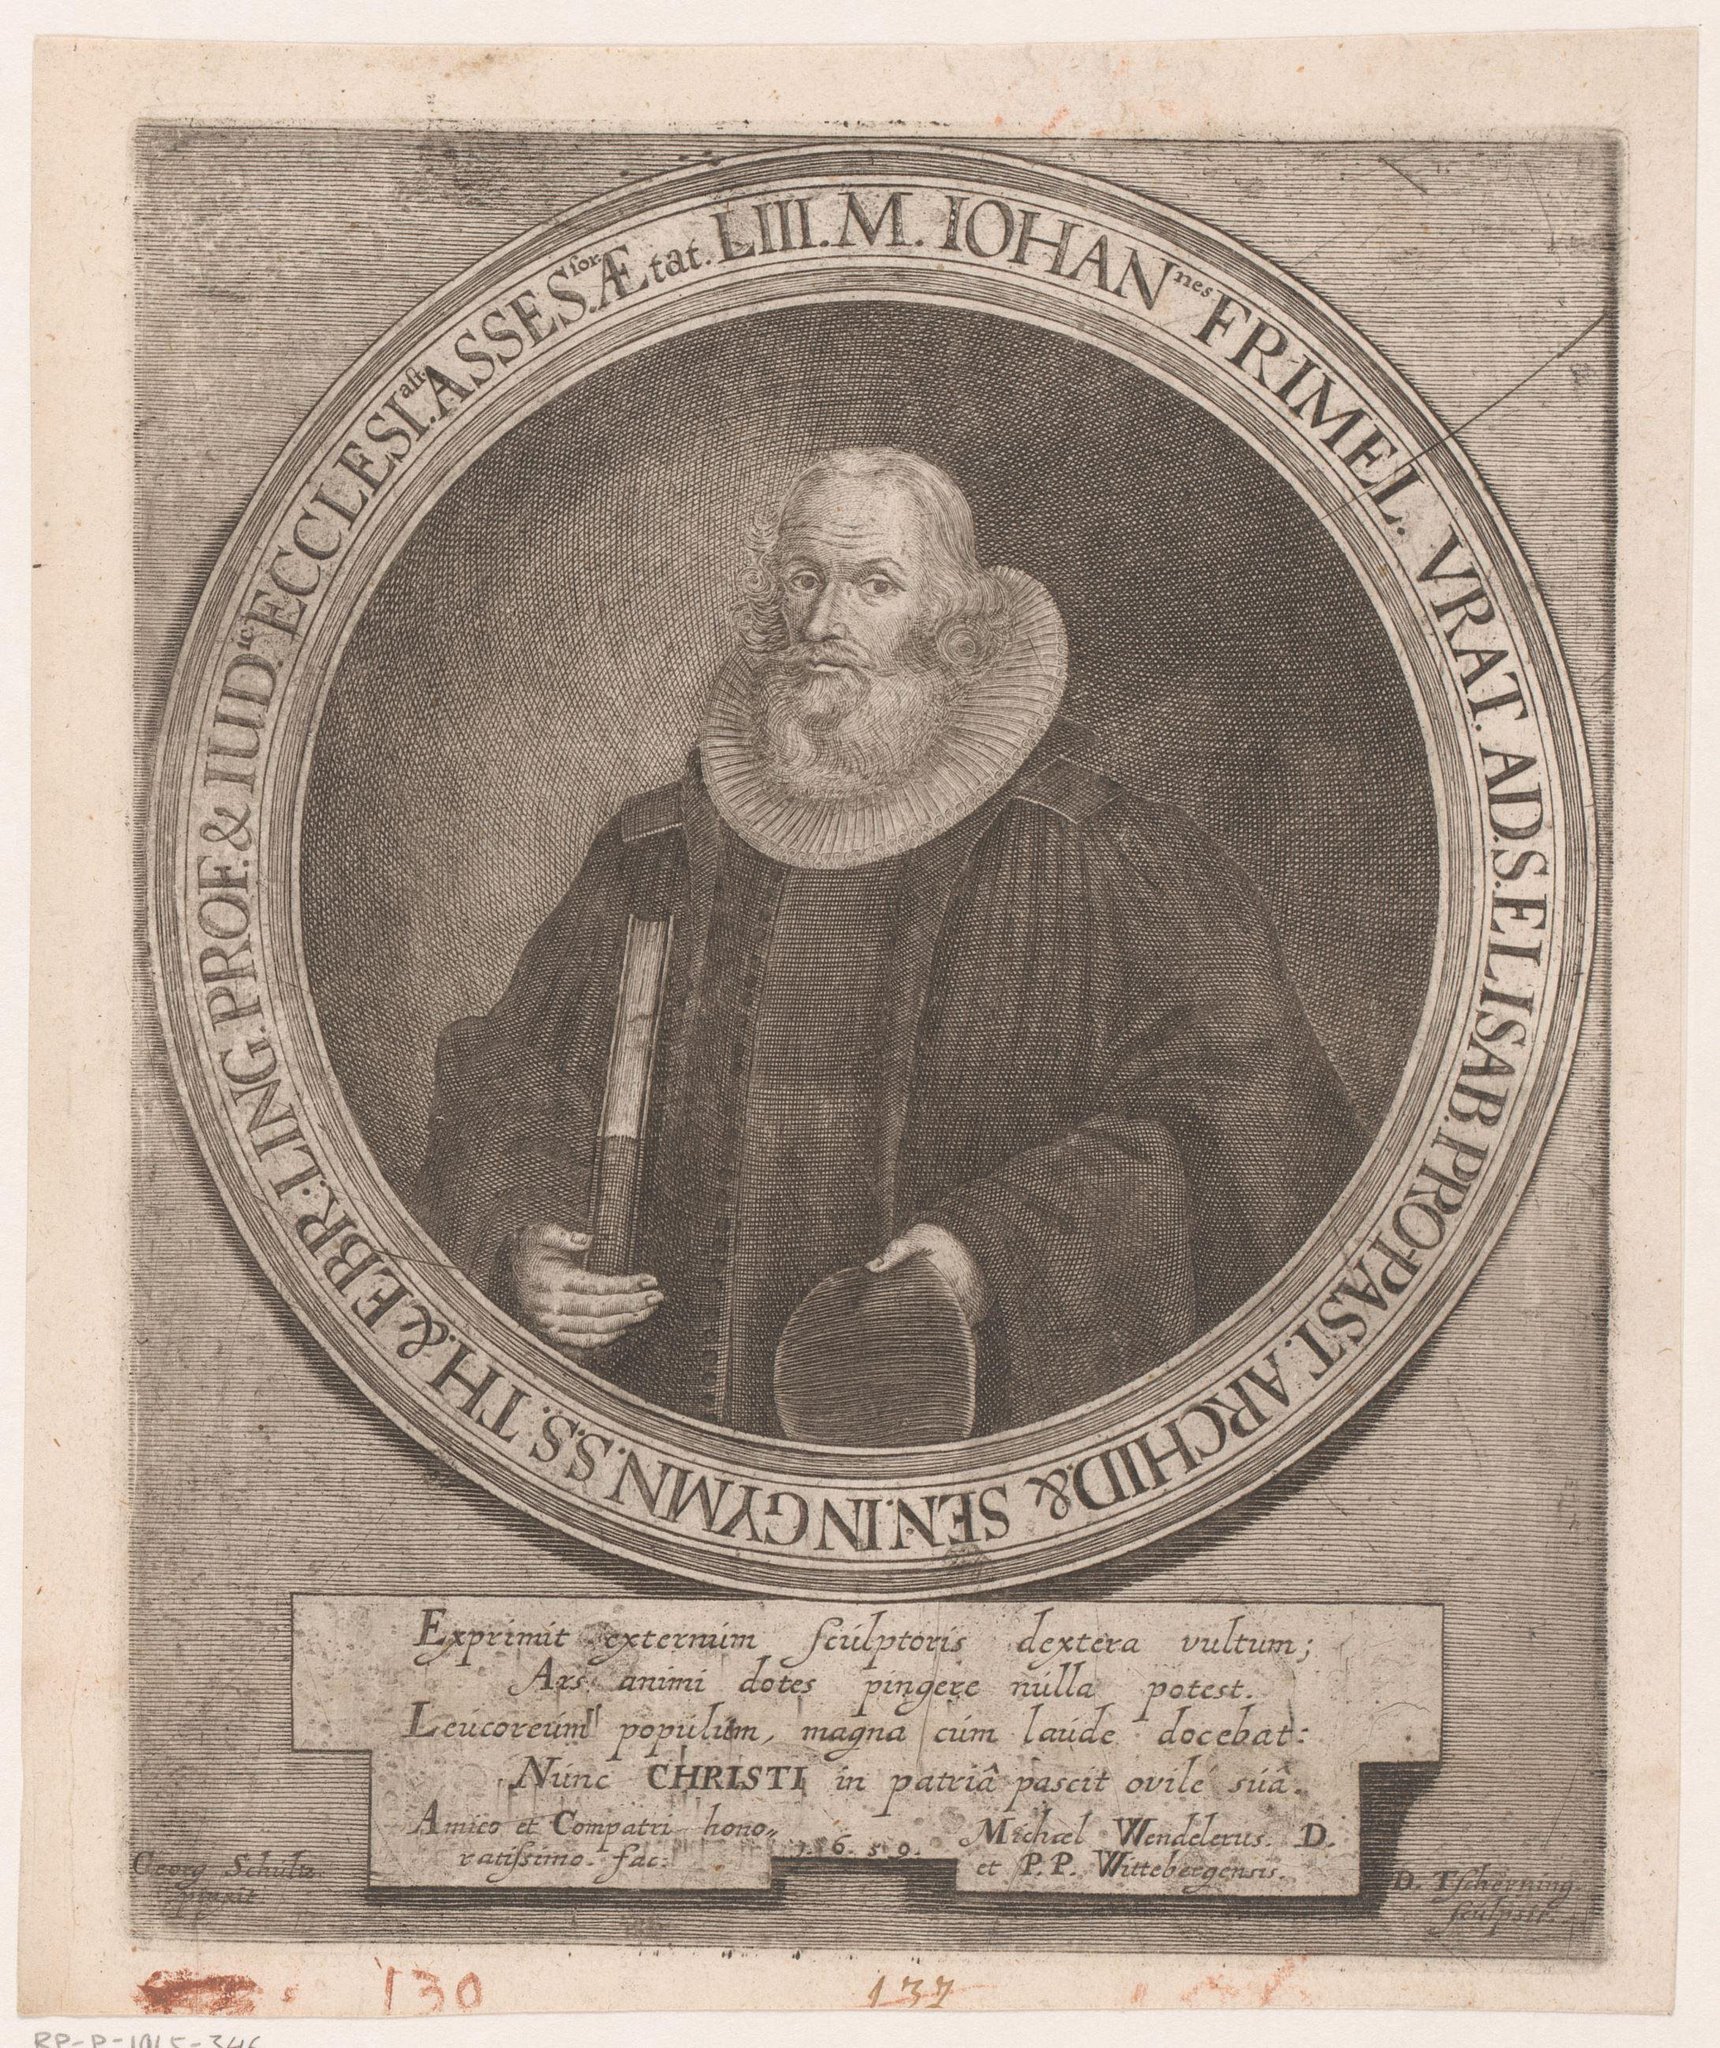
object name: print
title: Portret van Johann Frimel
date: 1659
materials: paper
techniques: engraving, intaglio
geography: germany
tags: johann frimel, historical persons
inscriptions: number: ‘132’, number: ‘130’, collector's mark: Lugt 2228